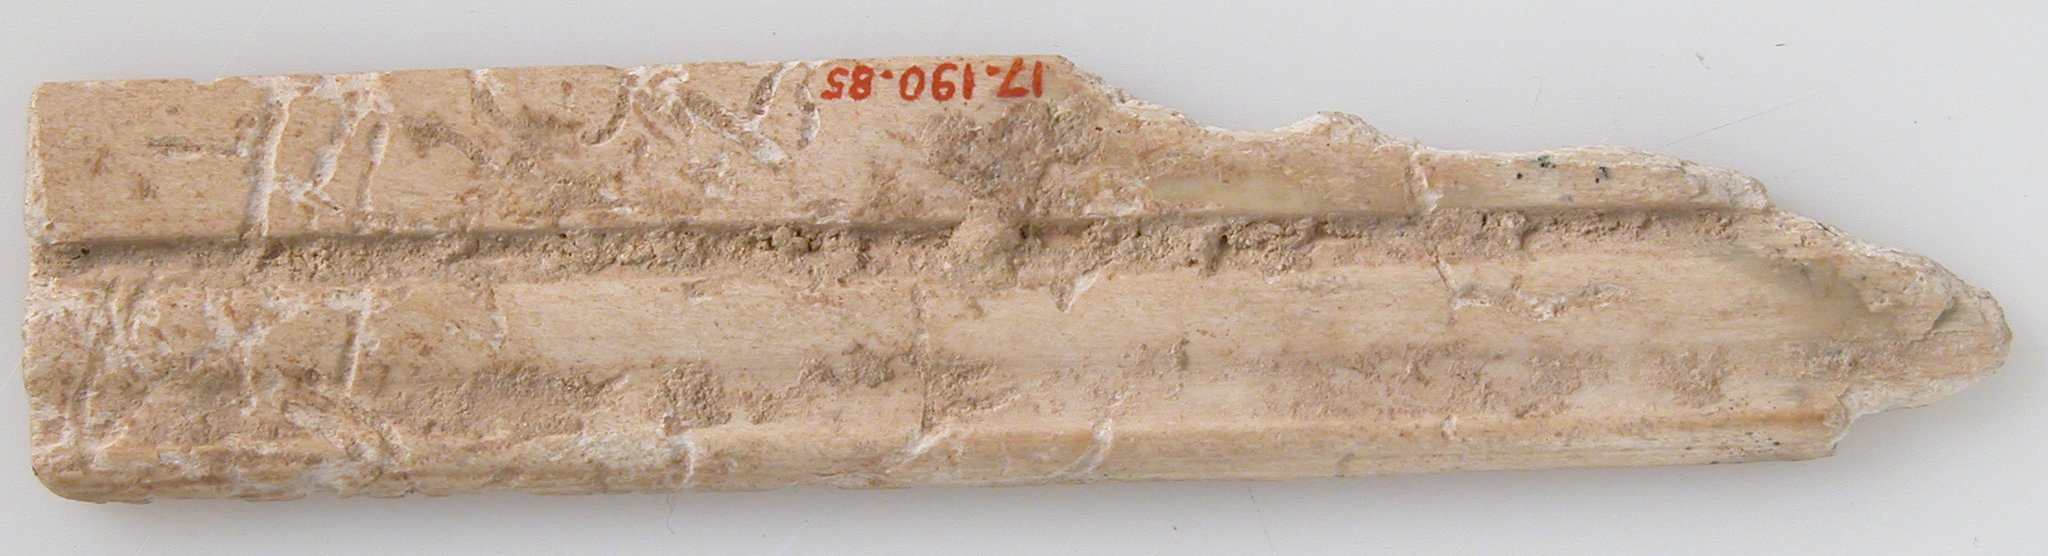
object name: fragment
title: Fragment of Molding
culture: coptic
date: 501-700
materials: ivory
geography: egypt